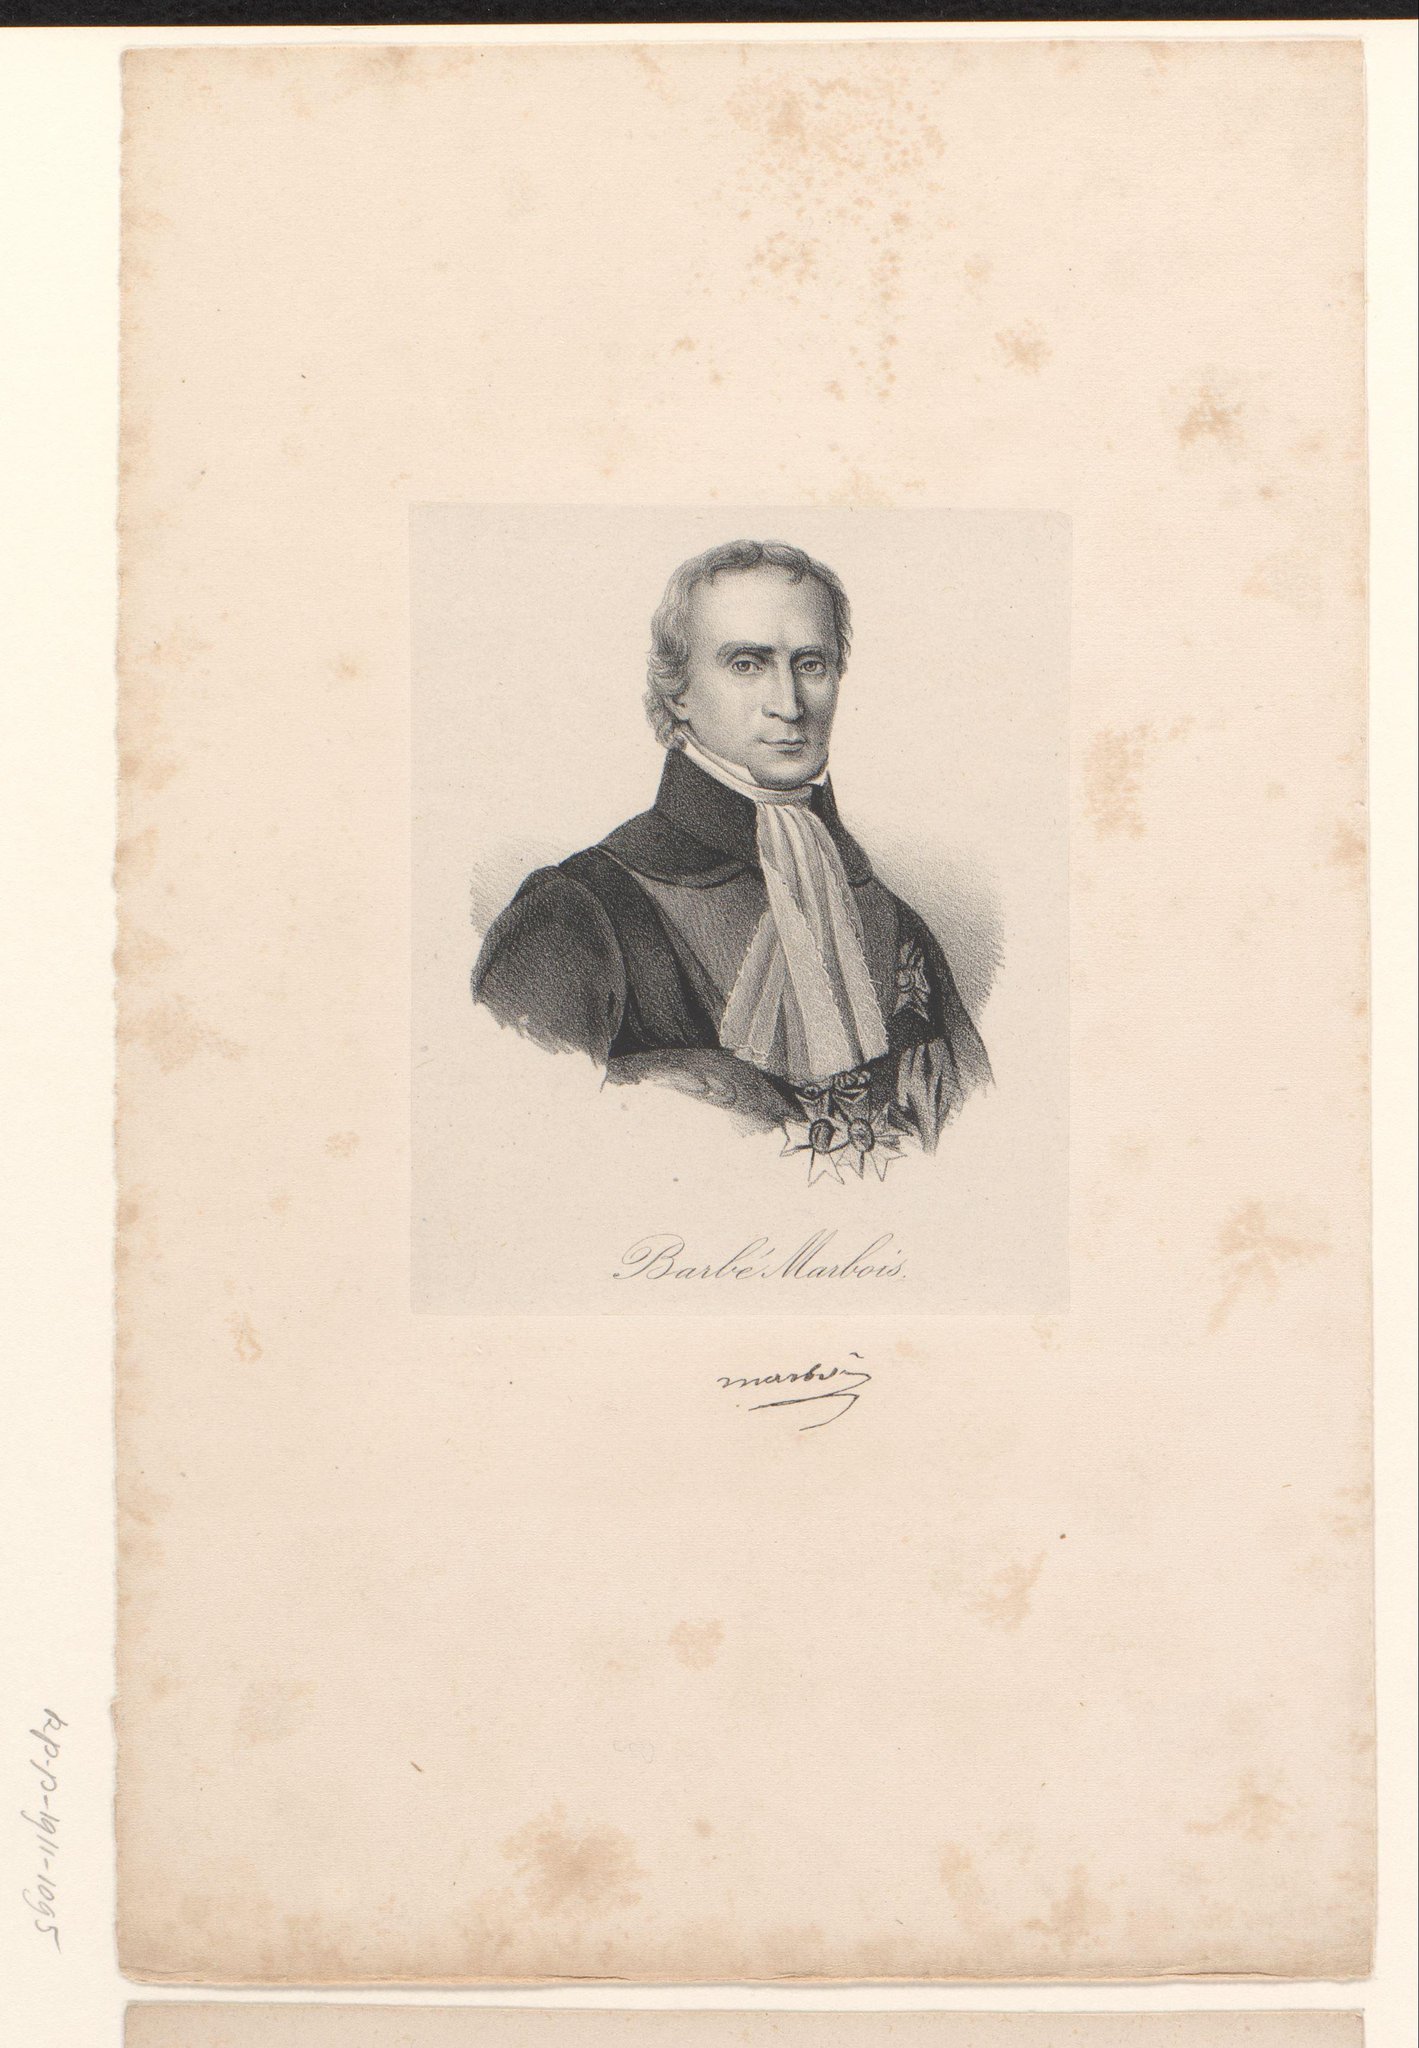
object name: print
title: Barbé Marbois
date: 1818-1842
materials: paper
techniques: lithograph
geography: paris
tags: paris, politician, historical persons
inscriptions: collector's mark: Lugt 2228a